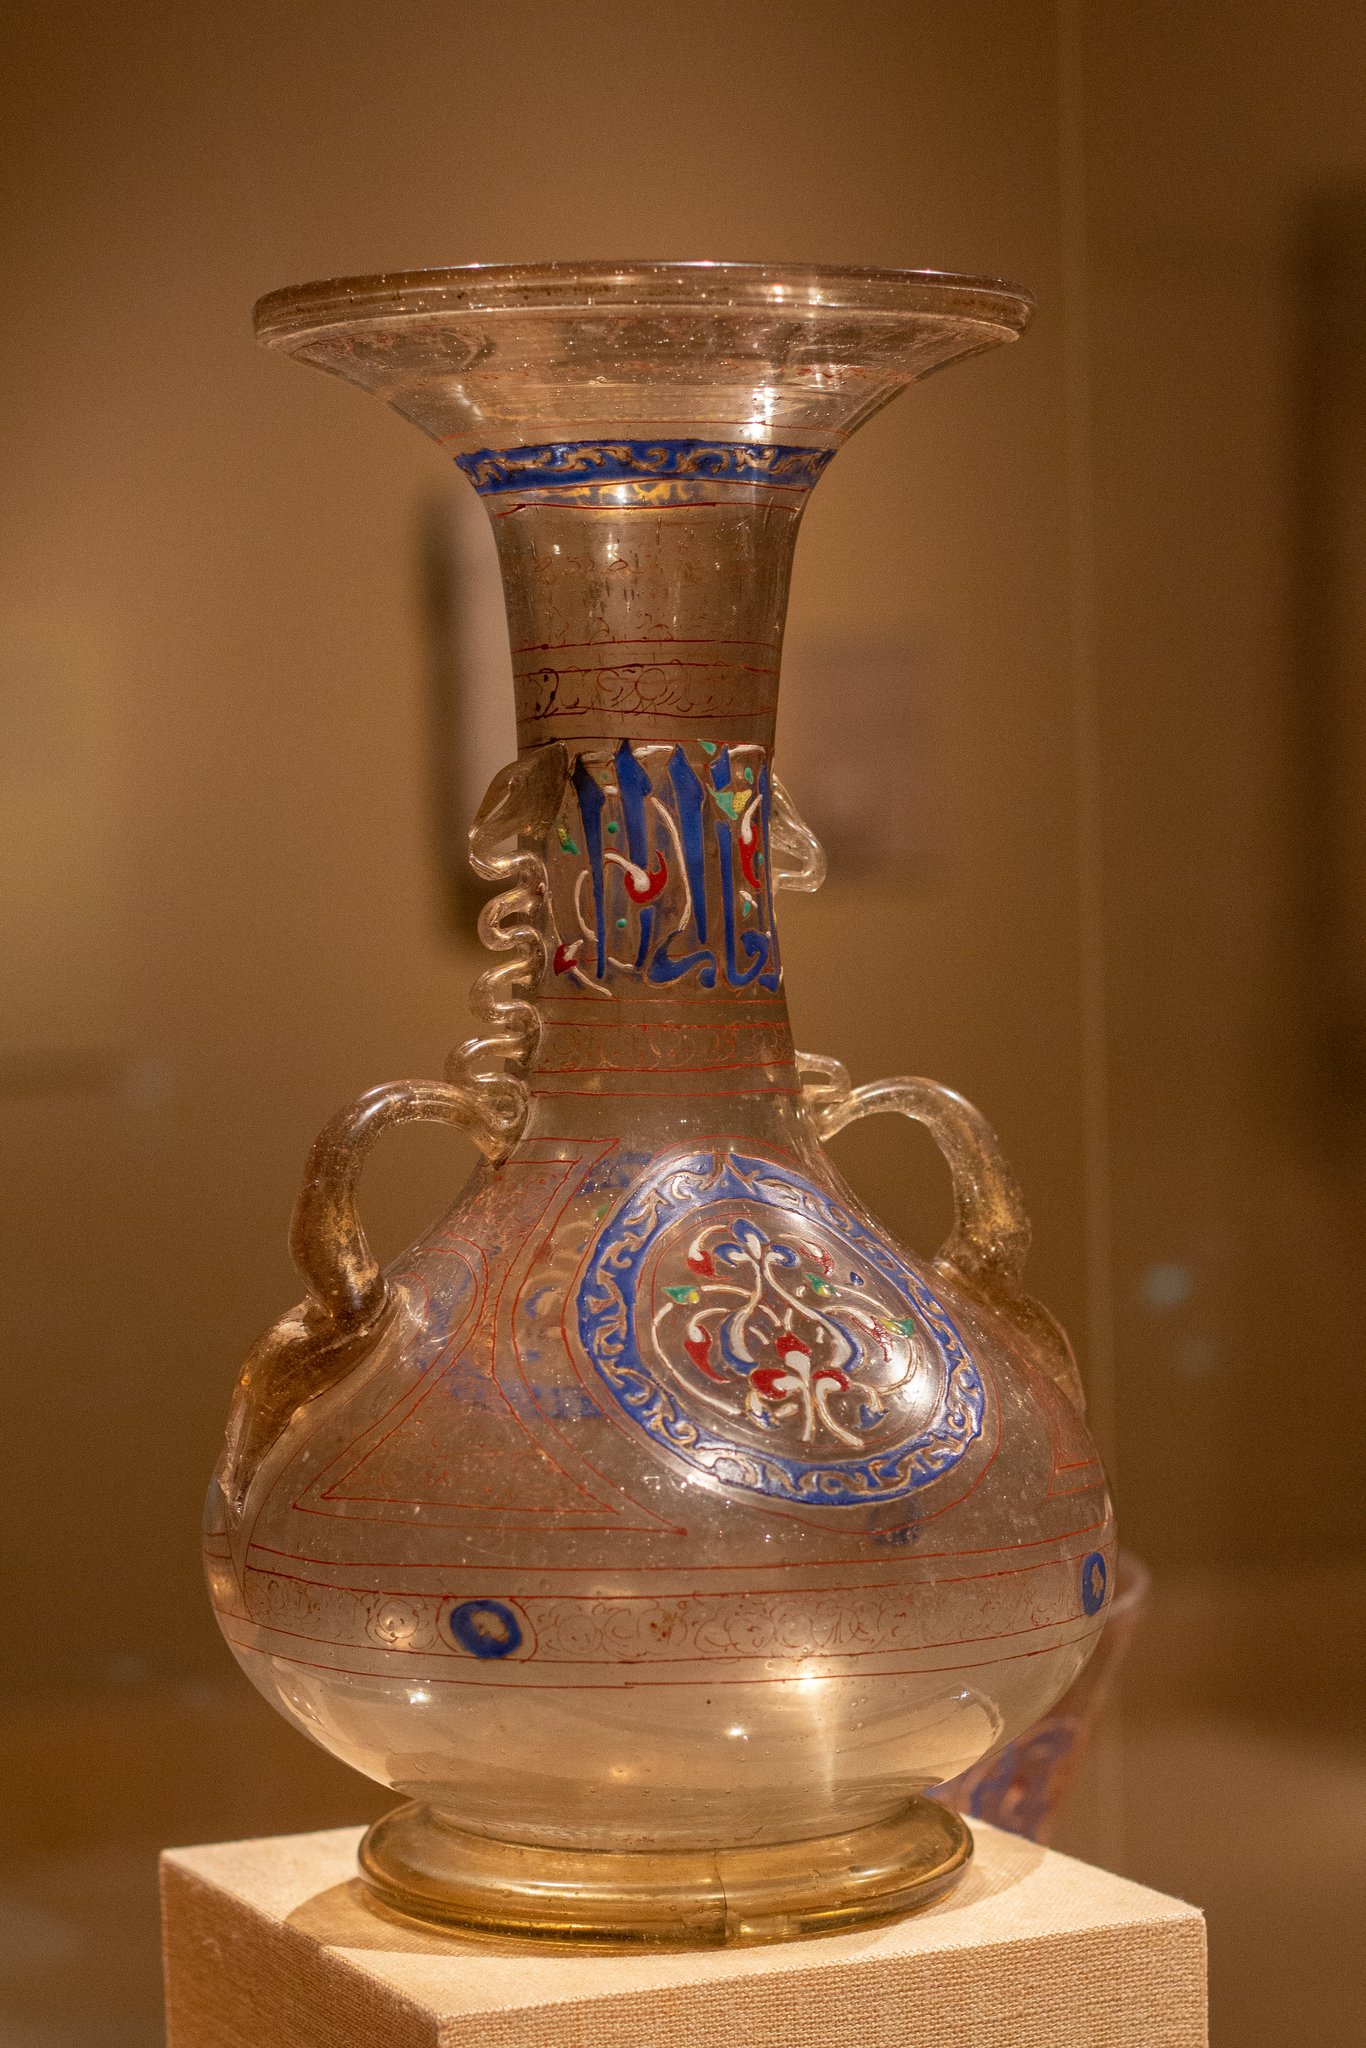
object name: vase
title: Vase with Handles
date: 1351-1400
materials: glass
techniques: glassblowing, enamel, gilding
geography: syria